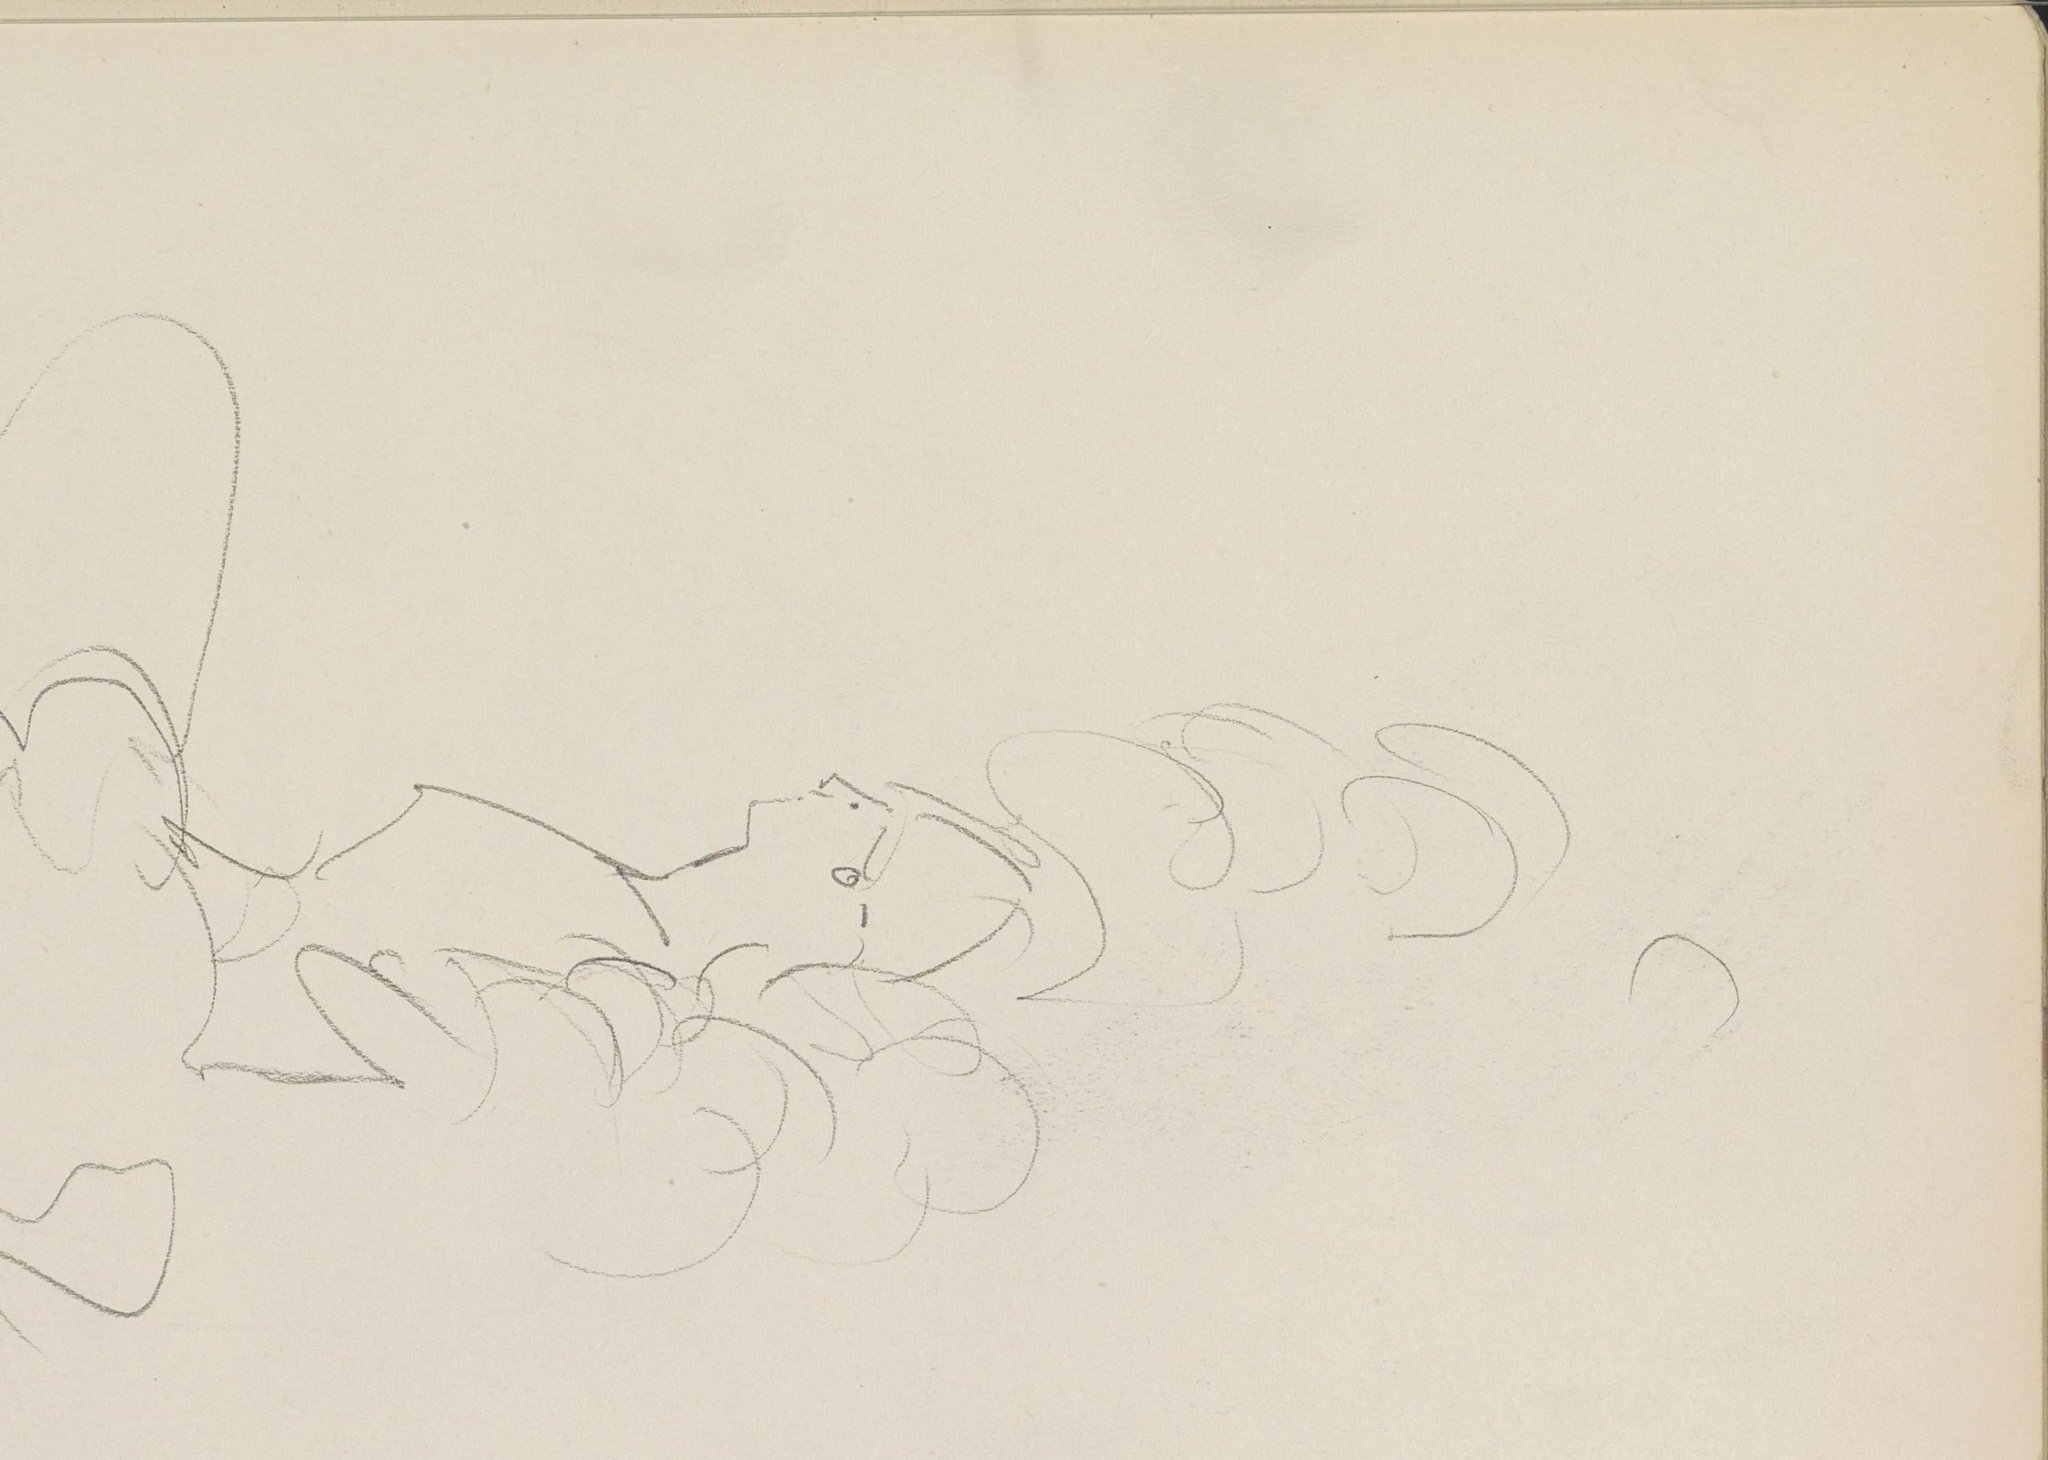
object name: sketchbook leaf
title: Revuedanseres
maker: isaac israels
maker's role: draughtsman, painter, print maker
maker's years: 1865-1934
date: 1915-1934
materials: paper, pencil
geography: the hague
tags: female dancer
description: Blad 5 recto uit schetsboek VI met 33 bladen.